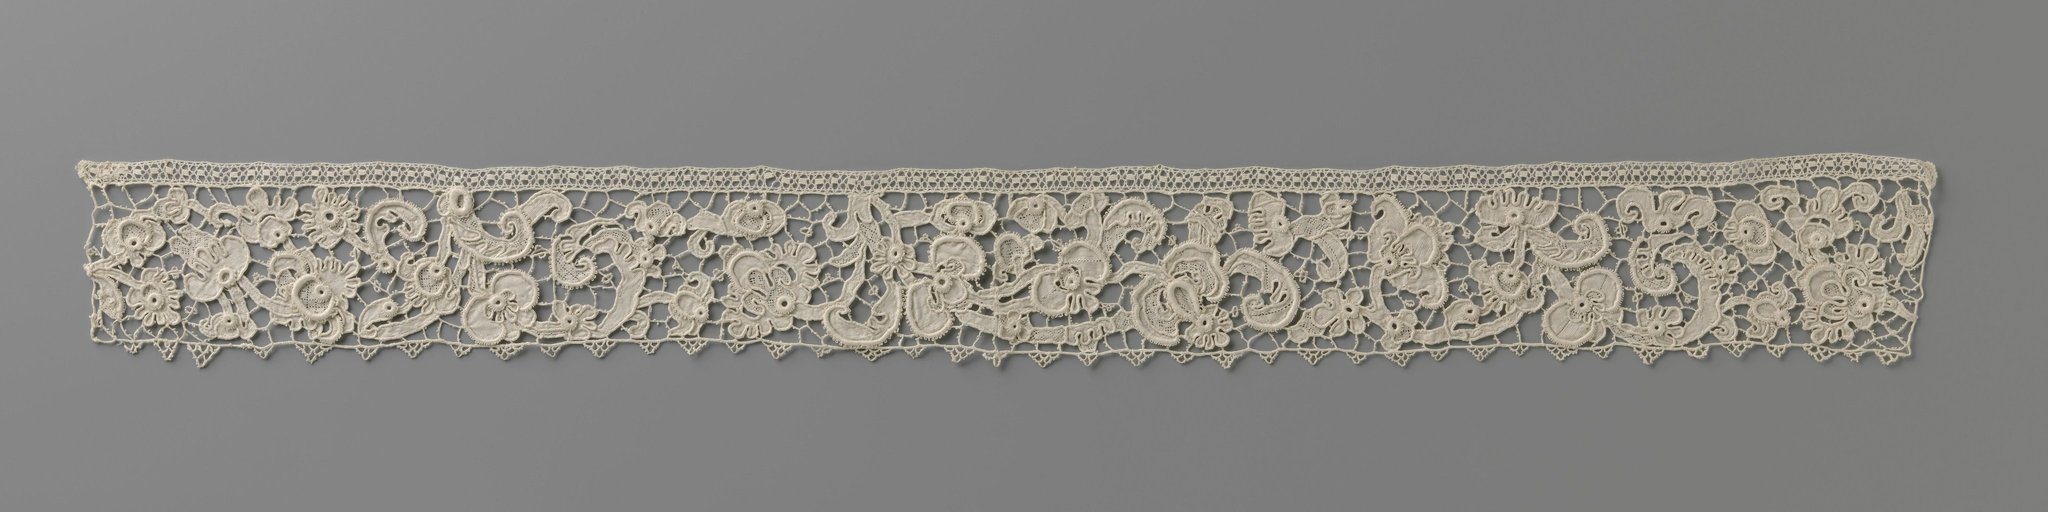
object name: strip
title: Strook naaldkant met dubbele ranken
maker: Anonymous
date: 1875-1909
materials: linen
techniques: embroidery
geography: burano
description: Strook naturelkleurige naaldkant: Venetiaanse reliëfkant. Los verspreide, kleine en middelgrote palmetbloemen groeien aan dikke, verdubbelde stengels, die aan de rechte binnenkant abrupt ontspringen. Een open spijlengrond vormt de ondergrond. Randje met driehoekjes.